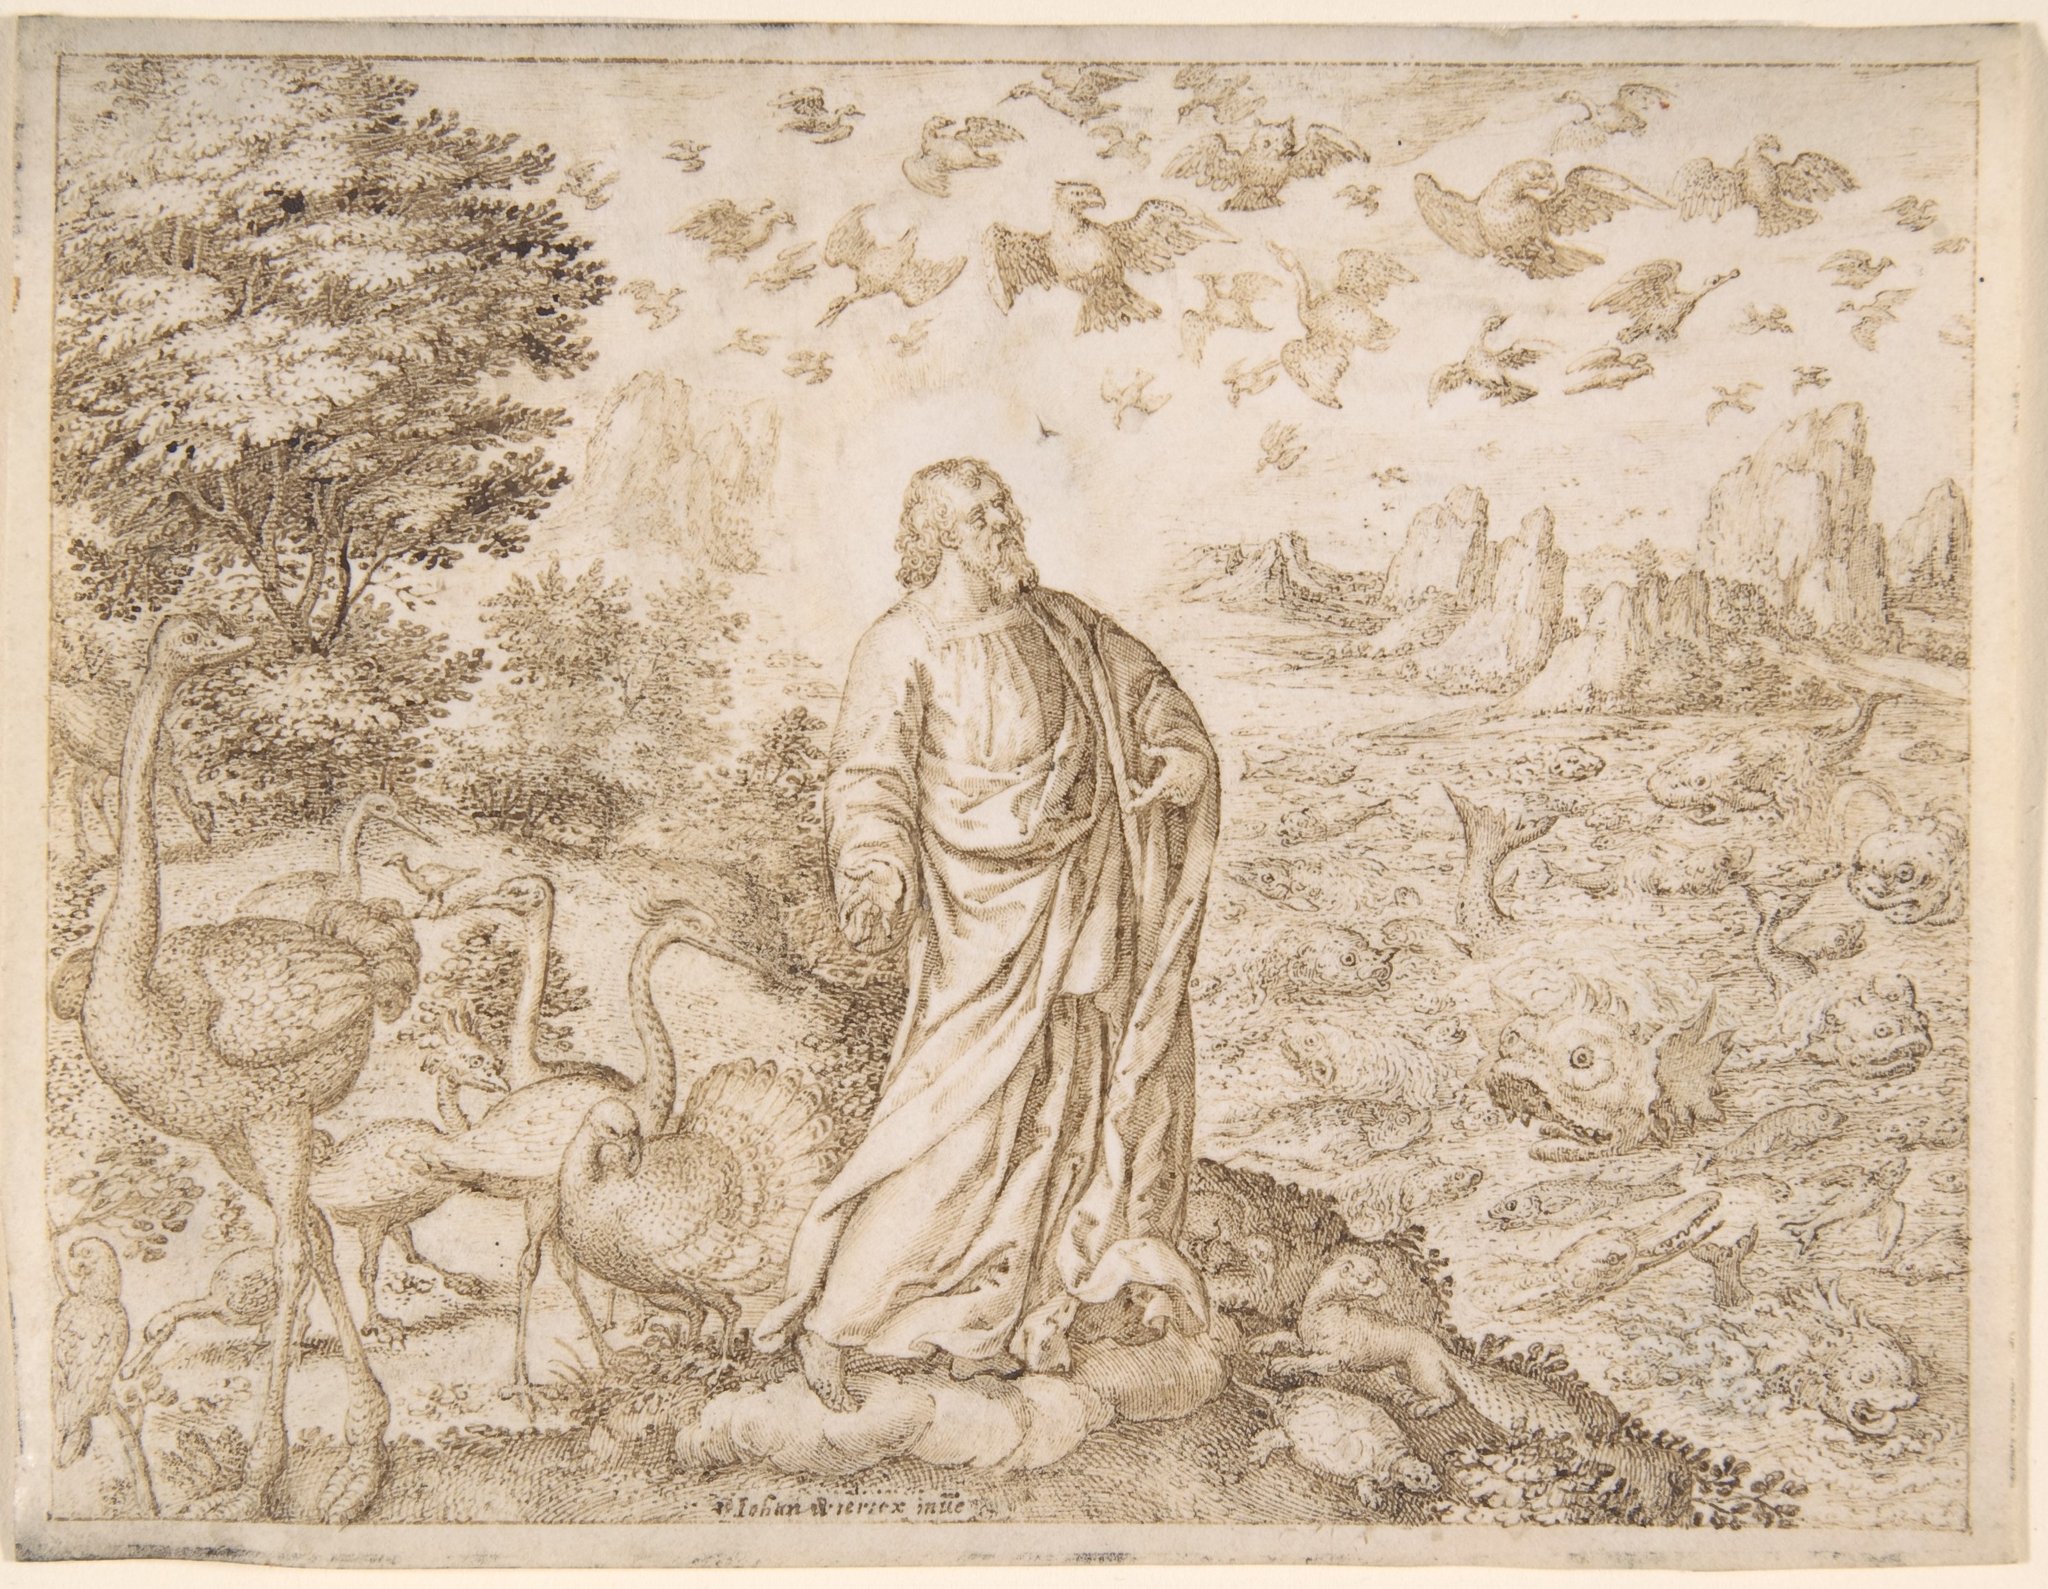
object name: drawing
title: The Creation of the Fish and the Birds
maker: jan (johannes) wierix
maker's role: artist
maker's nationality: netherlandish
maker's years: 1549-1615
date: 1534-1633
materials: ink, parchment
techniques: pen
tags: animals,birds,men,fish,trees